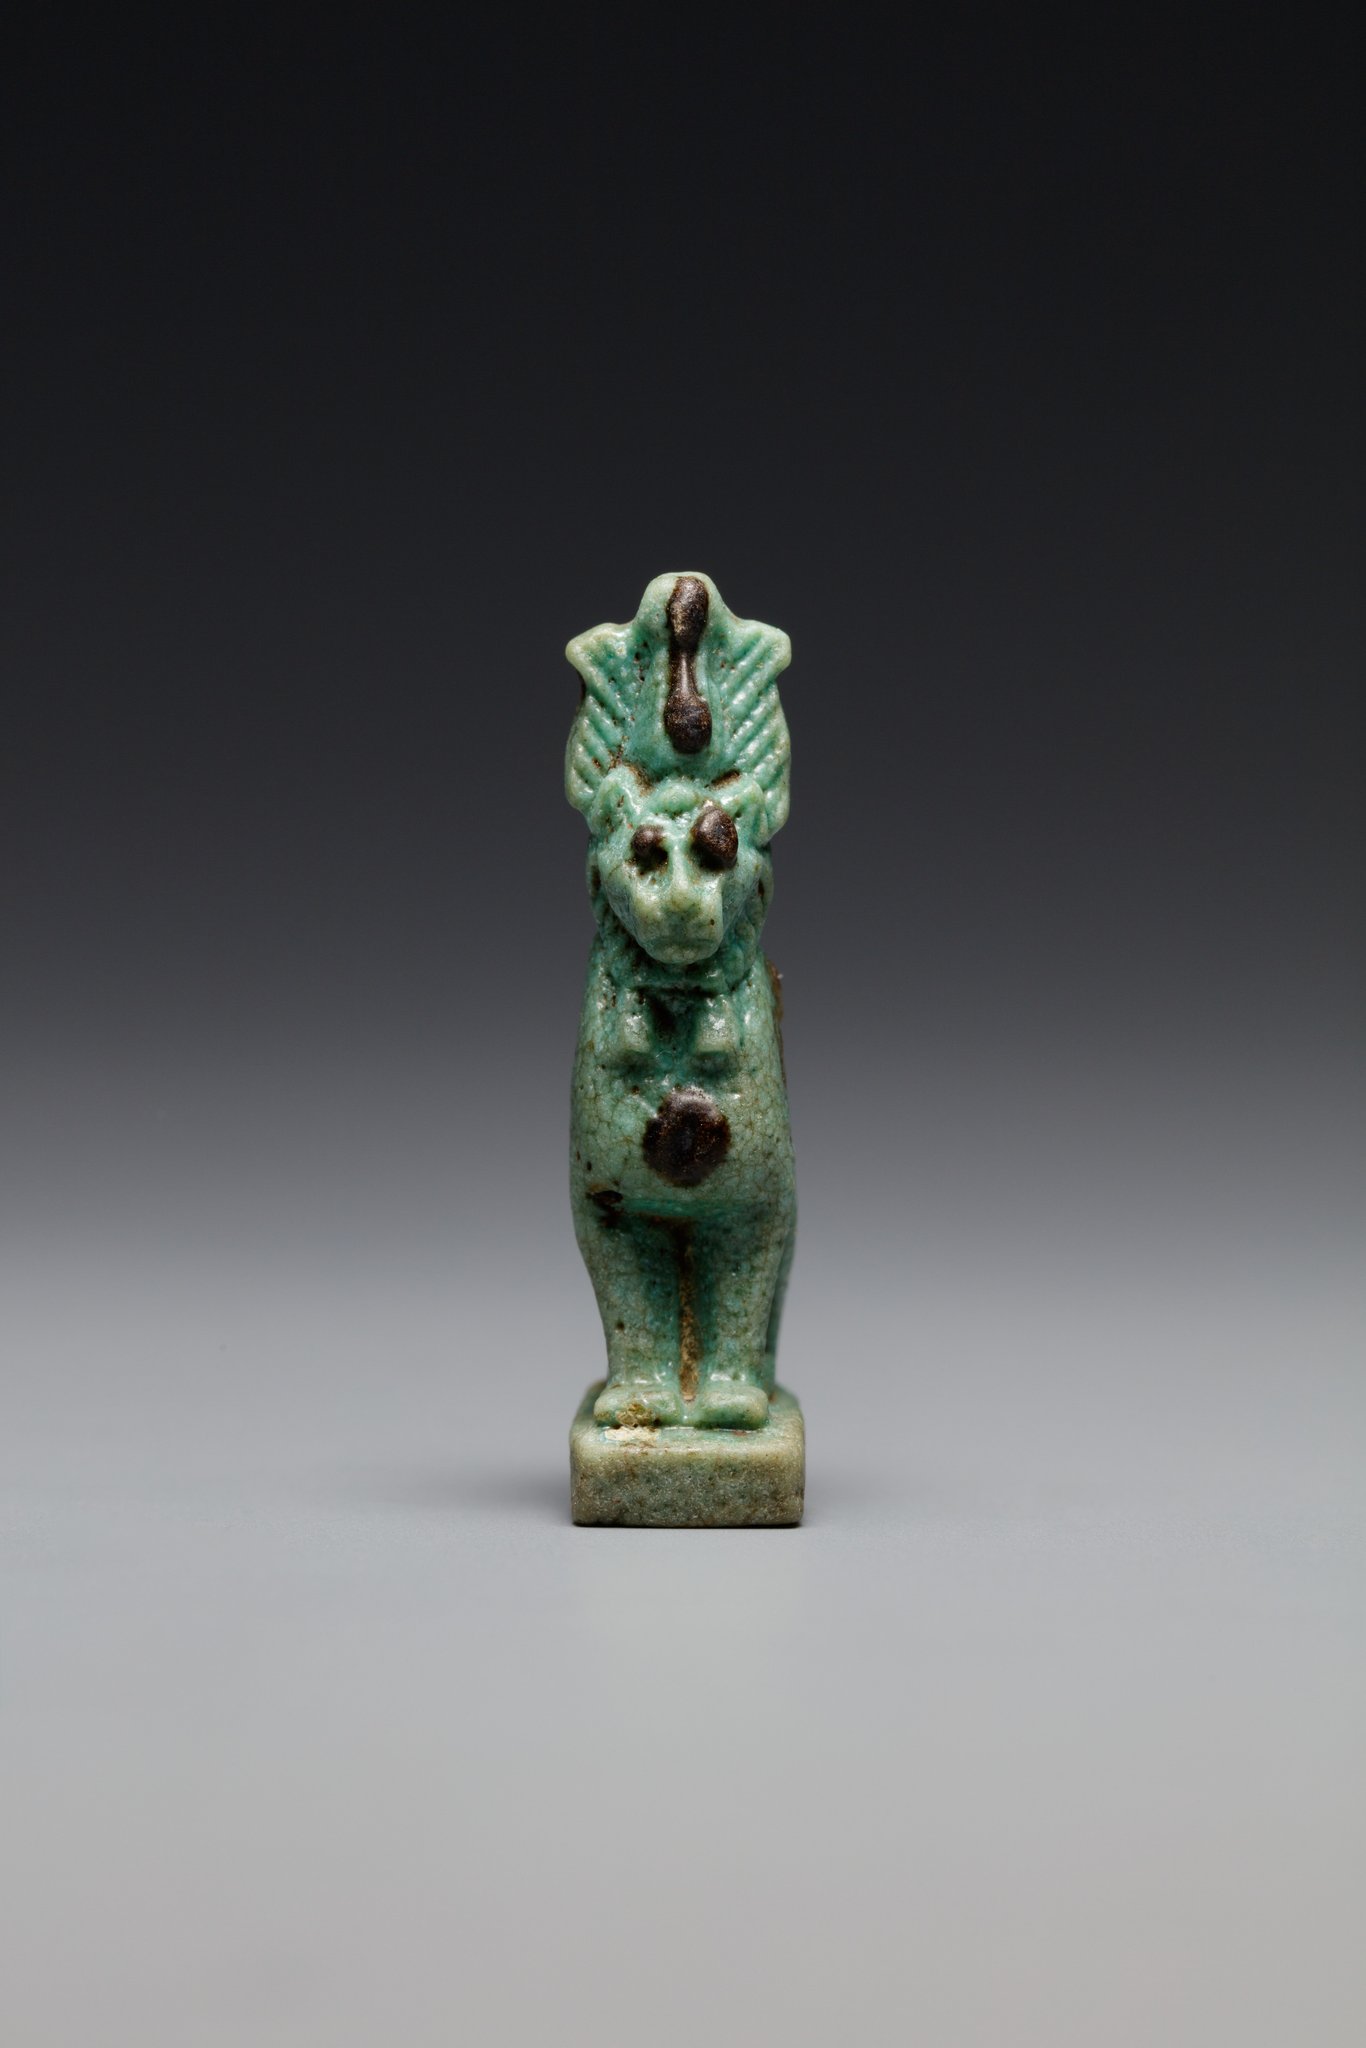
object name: amulet, lion, atef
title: Lion(?) wearing an atef crown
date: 664-525 BCE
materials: faience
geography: egypt